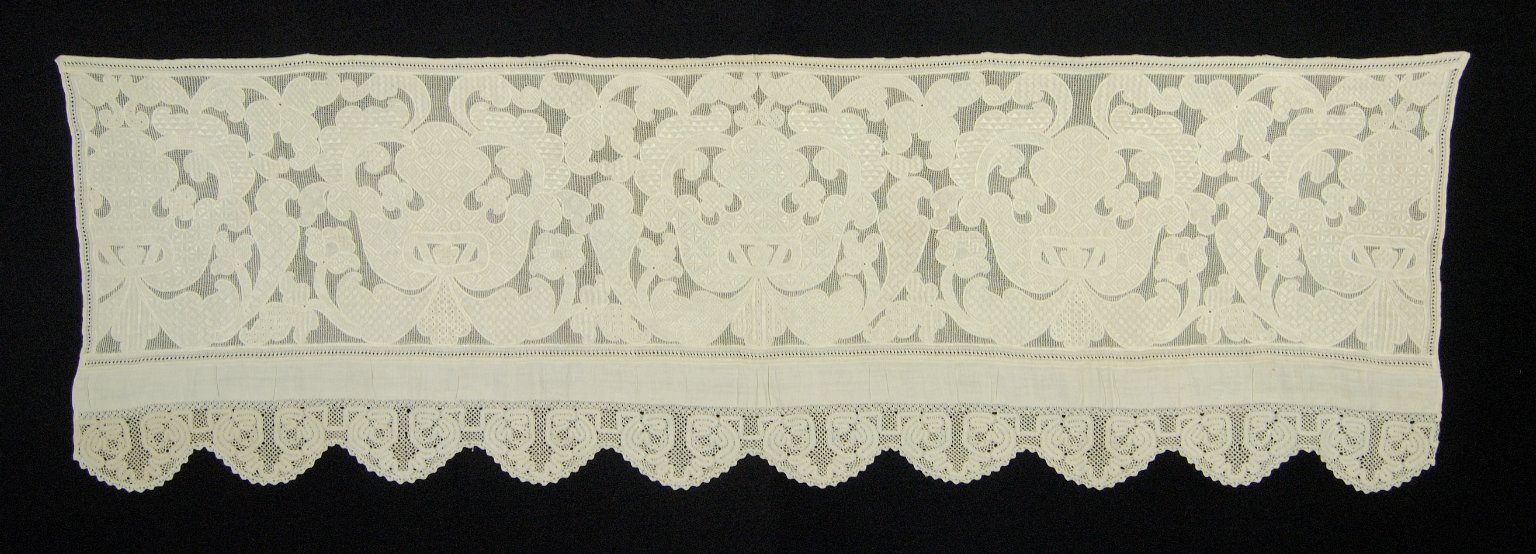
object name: border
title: Bed curtain border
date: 1800-1850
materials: linen